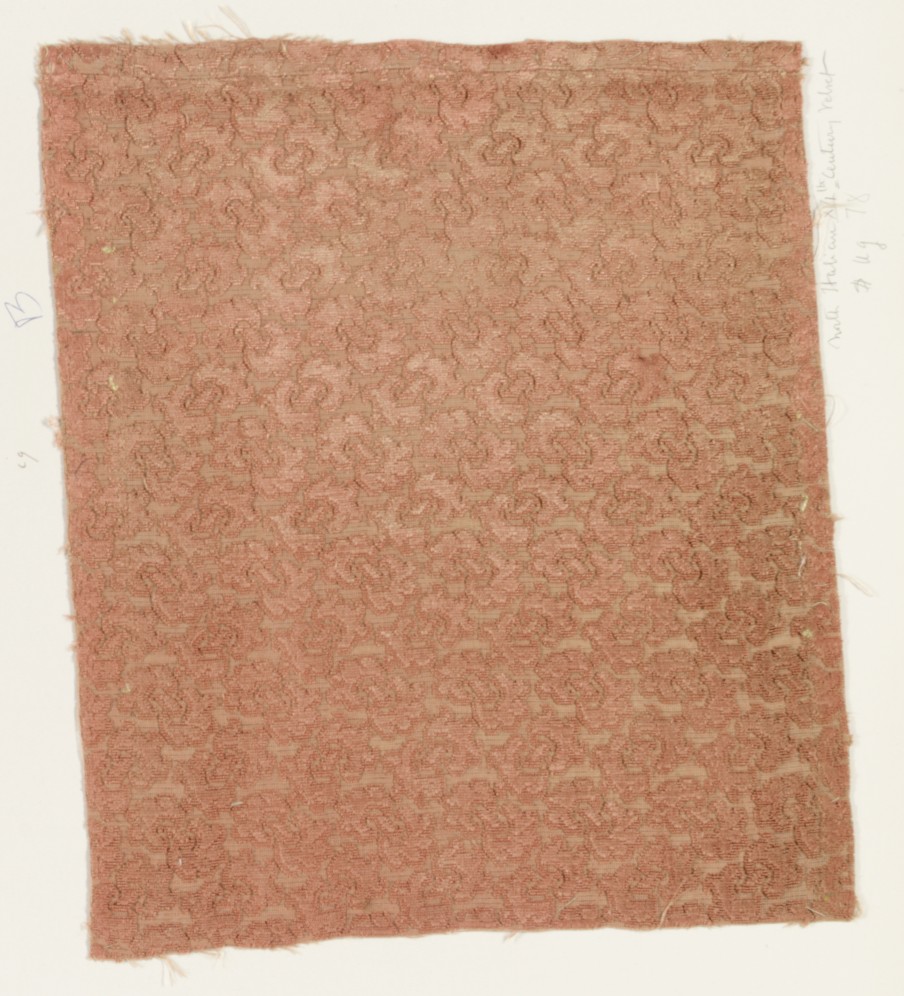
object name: fragment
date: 1501-1600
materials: metal thread, silk